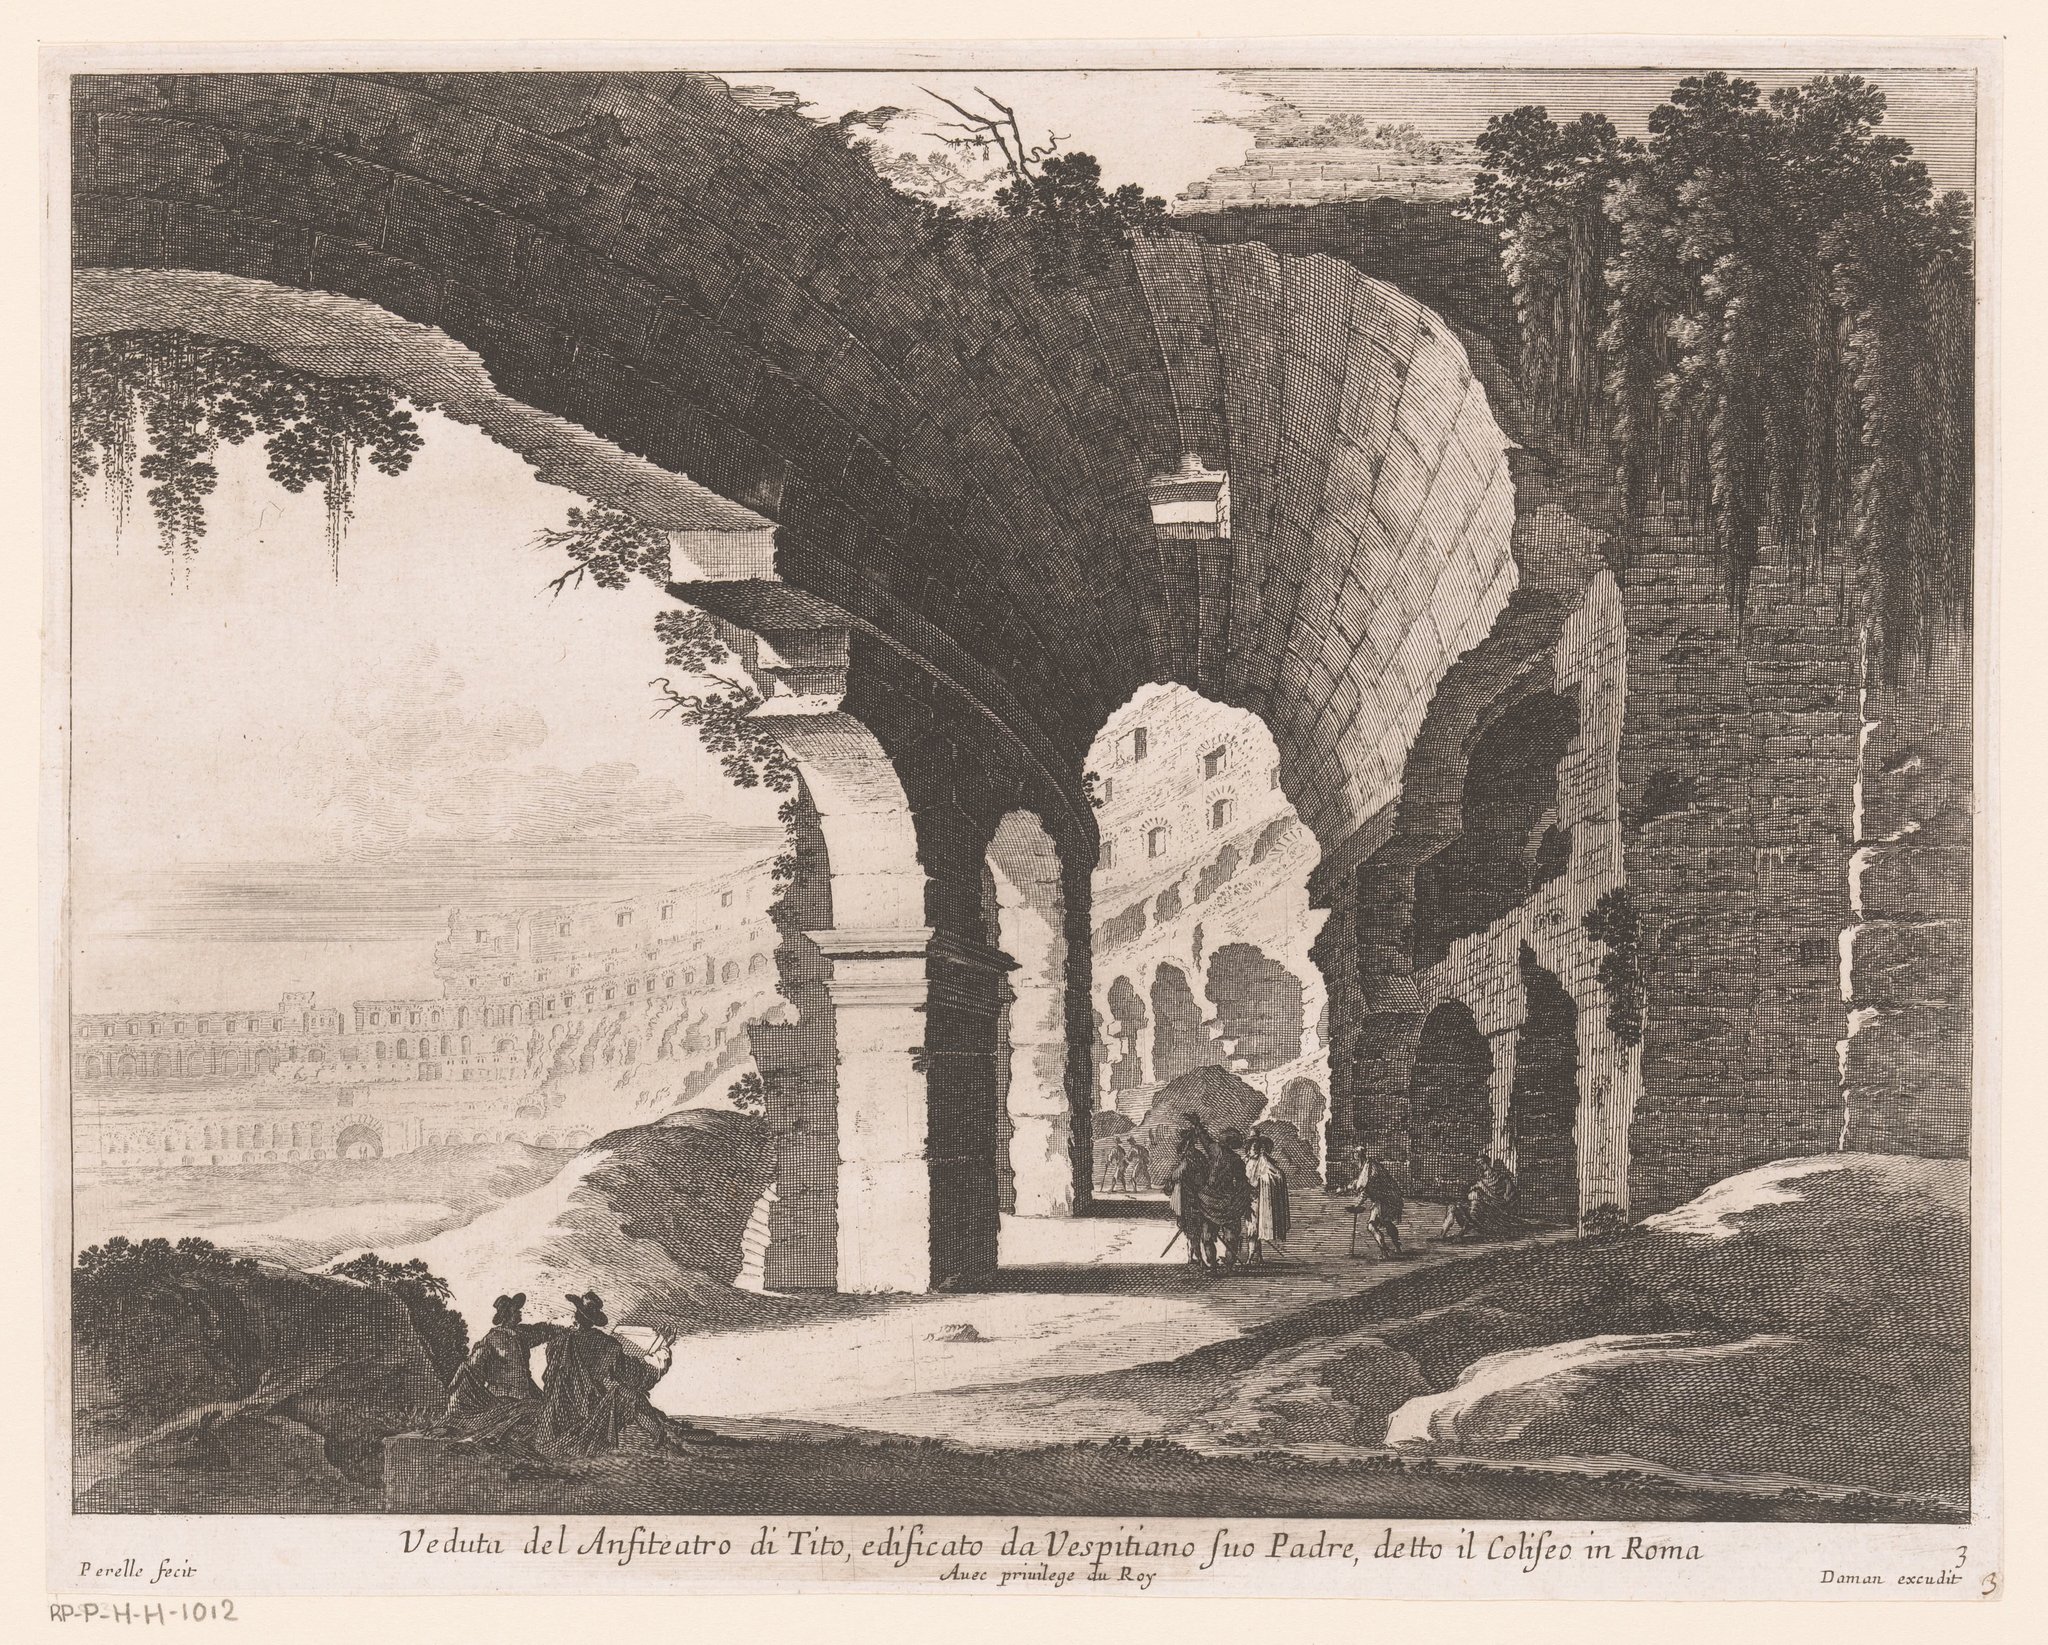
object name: print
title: Gezicht op het interieur van het Colosseum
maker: daman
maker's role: publisher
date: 1640-1660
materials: paper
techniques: engraving, etching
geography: france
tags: ruin of a building ~ architecture, amphitheatre, landscape with ruins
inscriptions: collector's mark: Lugt 11, collector's mark: Lugt 10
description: Prenten met het signatuur 'Perelle' kunnen zowel door vader Gabriel als door zonen Nicolas en Adam gemaakt zijn.